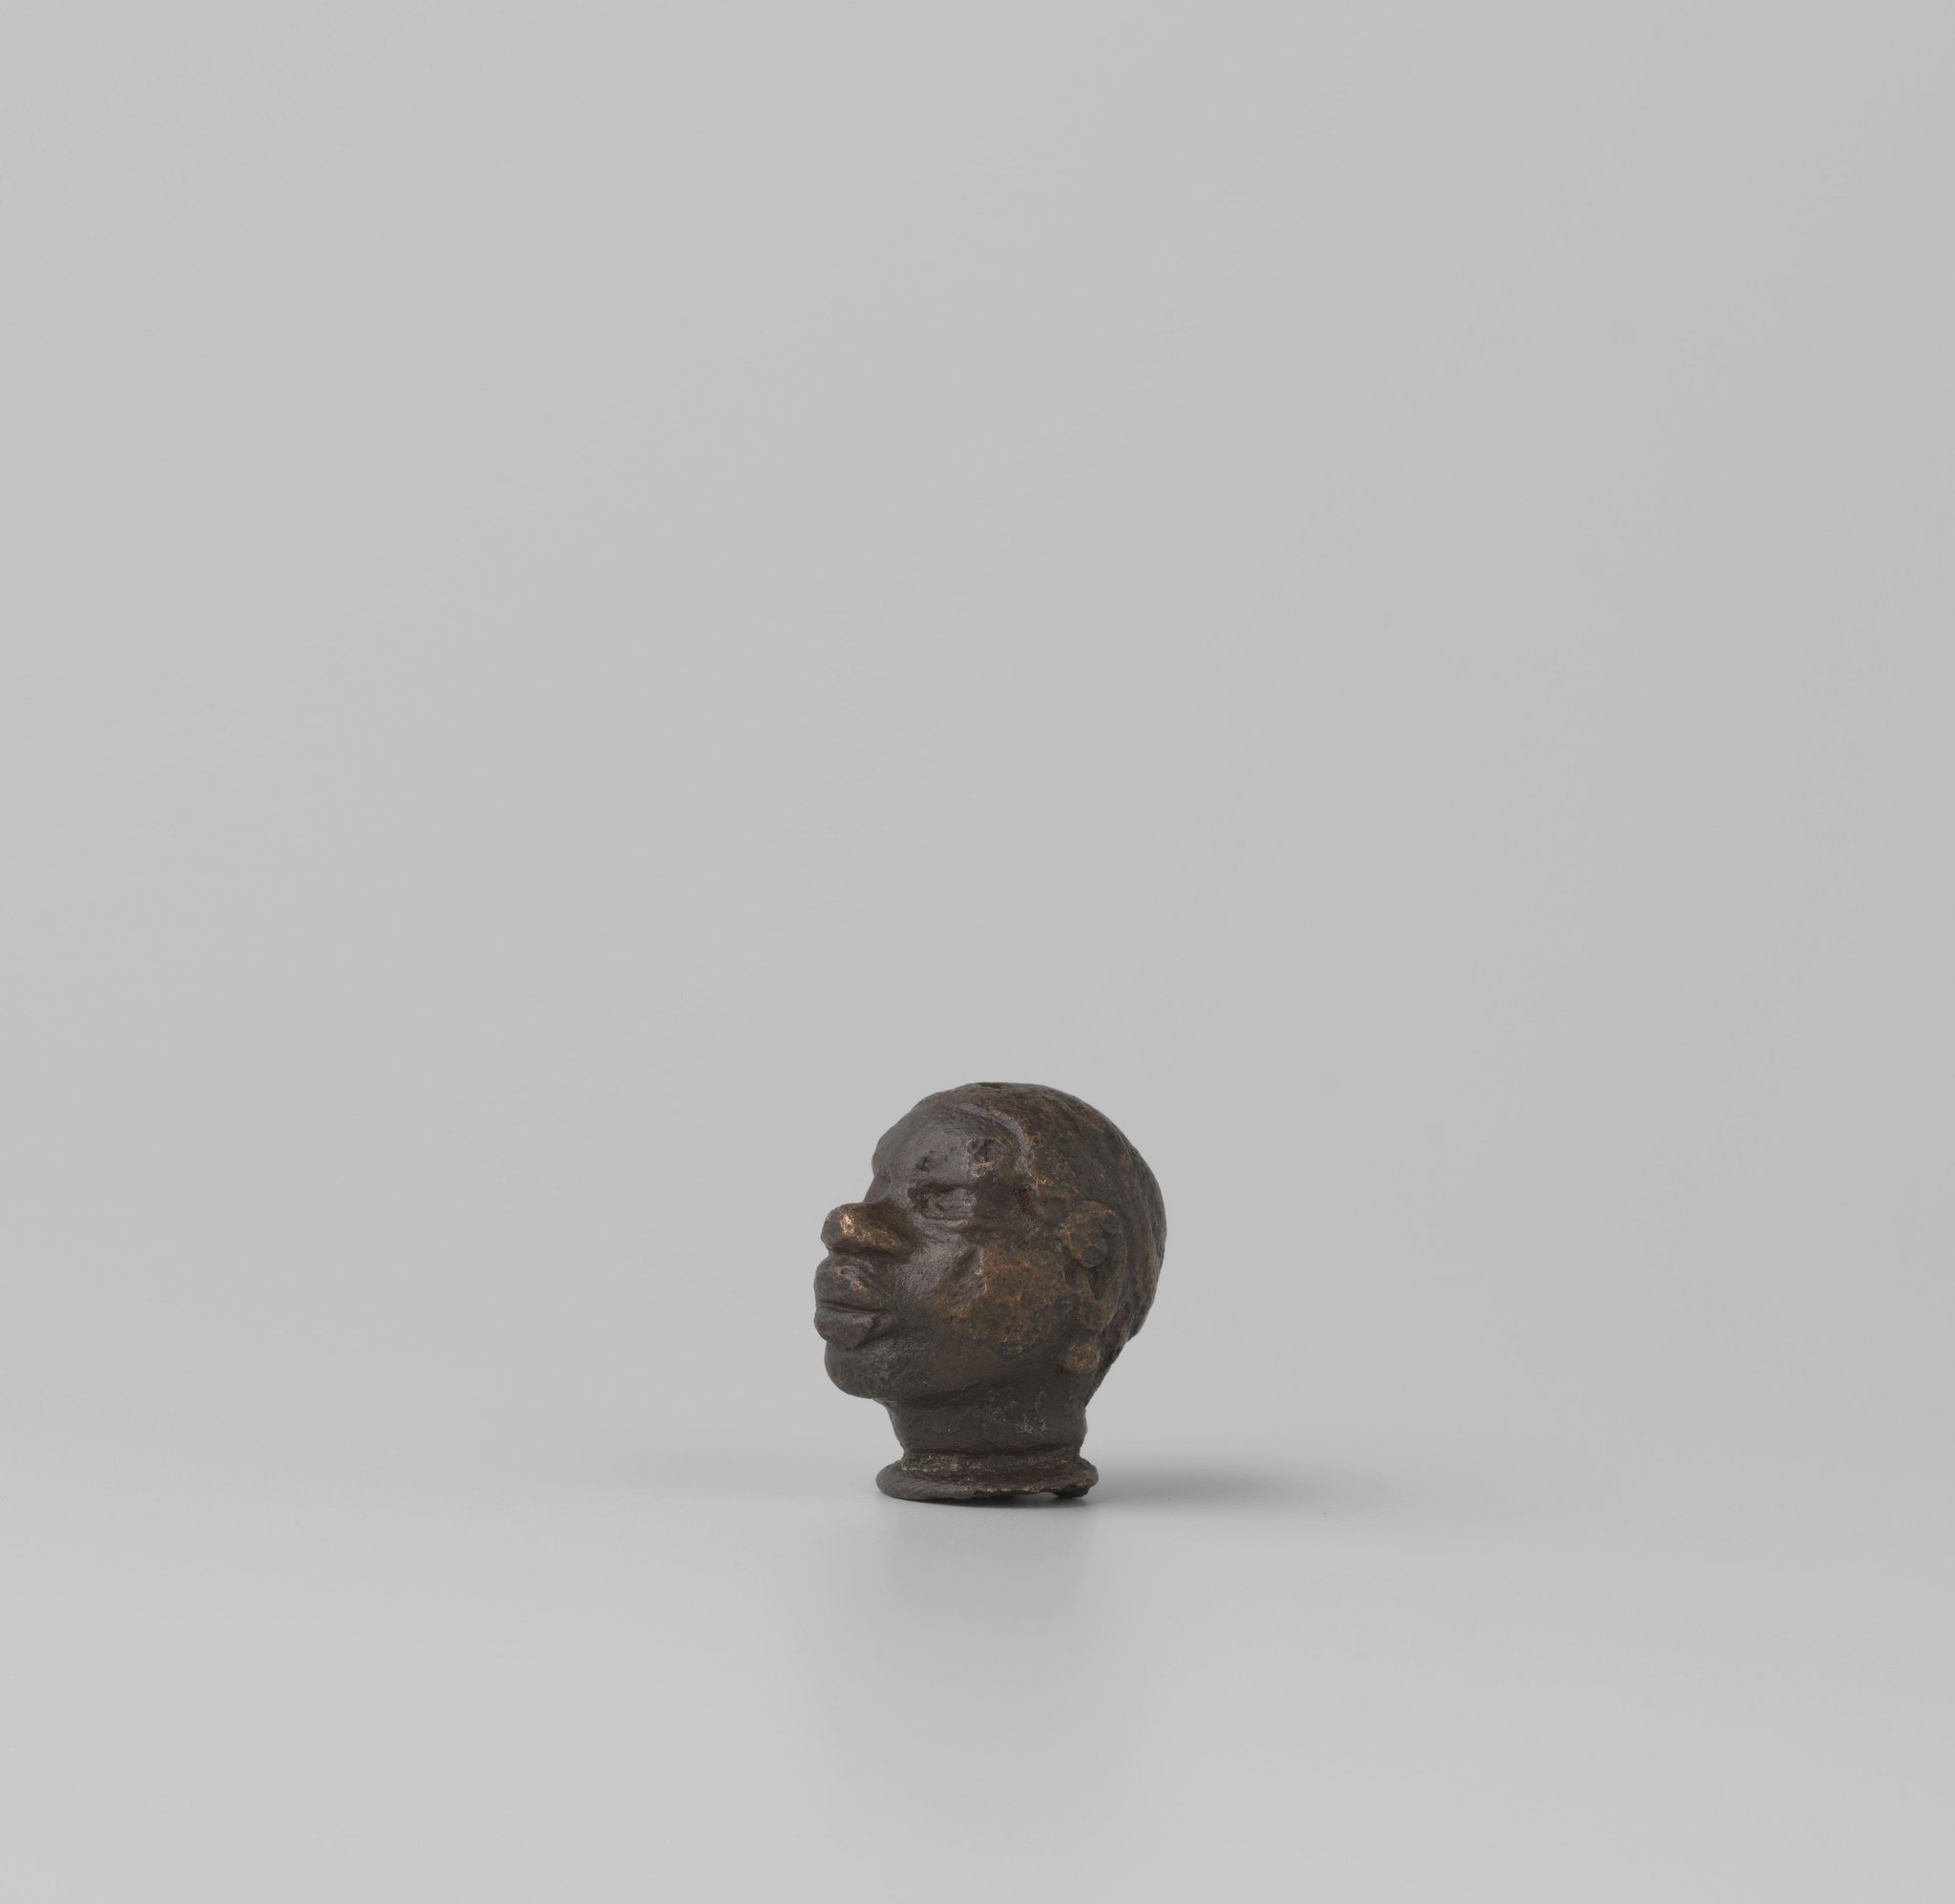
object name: pommel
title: Rapierknop met voorstelling van een Afrikaanse man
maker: Anonymous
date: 1580-1650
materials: bronze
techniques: casting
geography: germany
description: Knop (pommel) van een rapier met een voorstelling van een Afrikaanse man.